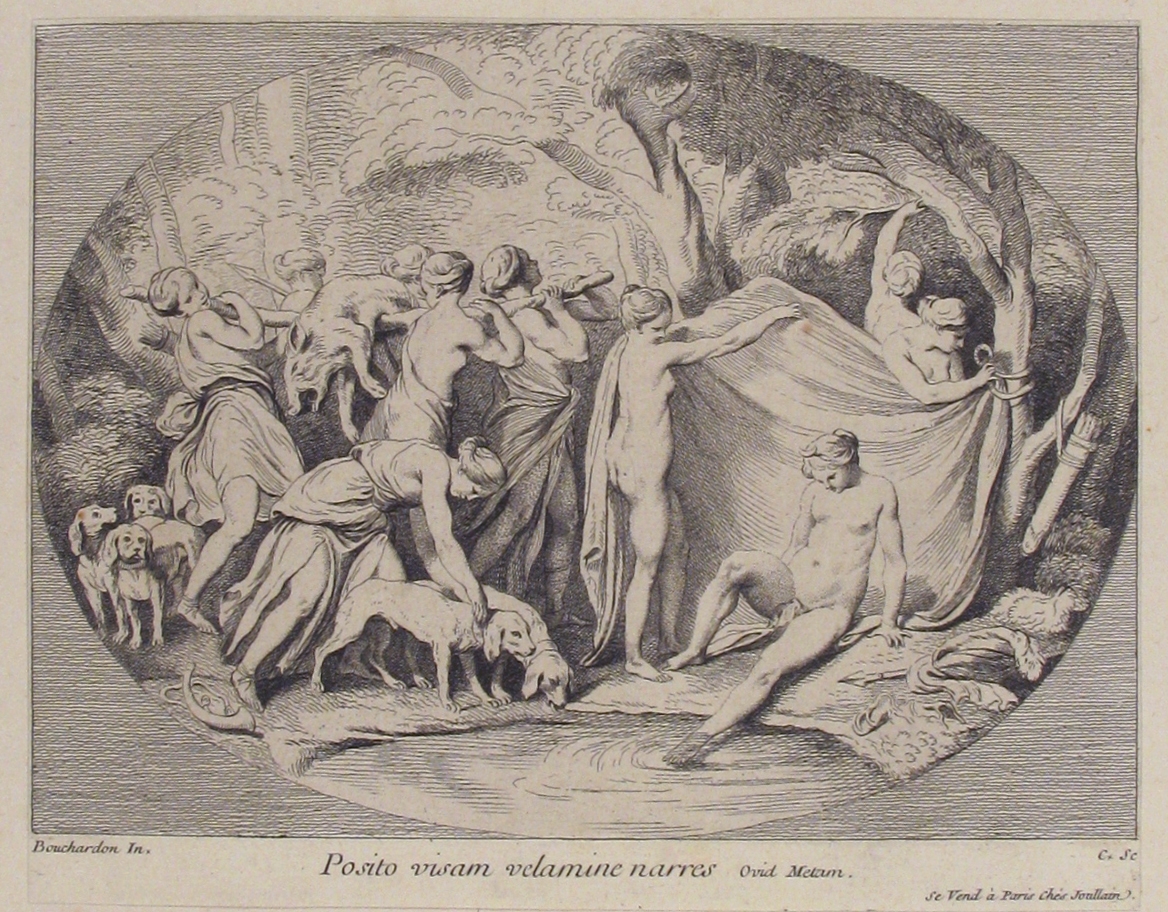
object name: print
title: Diana at the Bath After Returning from the Hunt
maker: anne claude philippe de tubières, comte de caylus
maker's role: artist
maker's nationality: french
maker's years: 1692-1765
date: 1730-1760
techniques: etching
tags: animals,female nudes,diana,trees,bathing